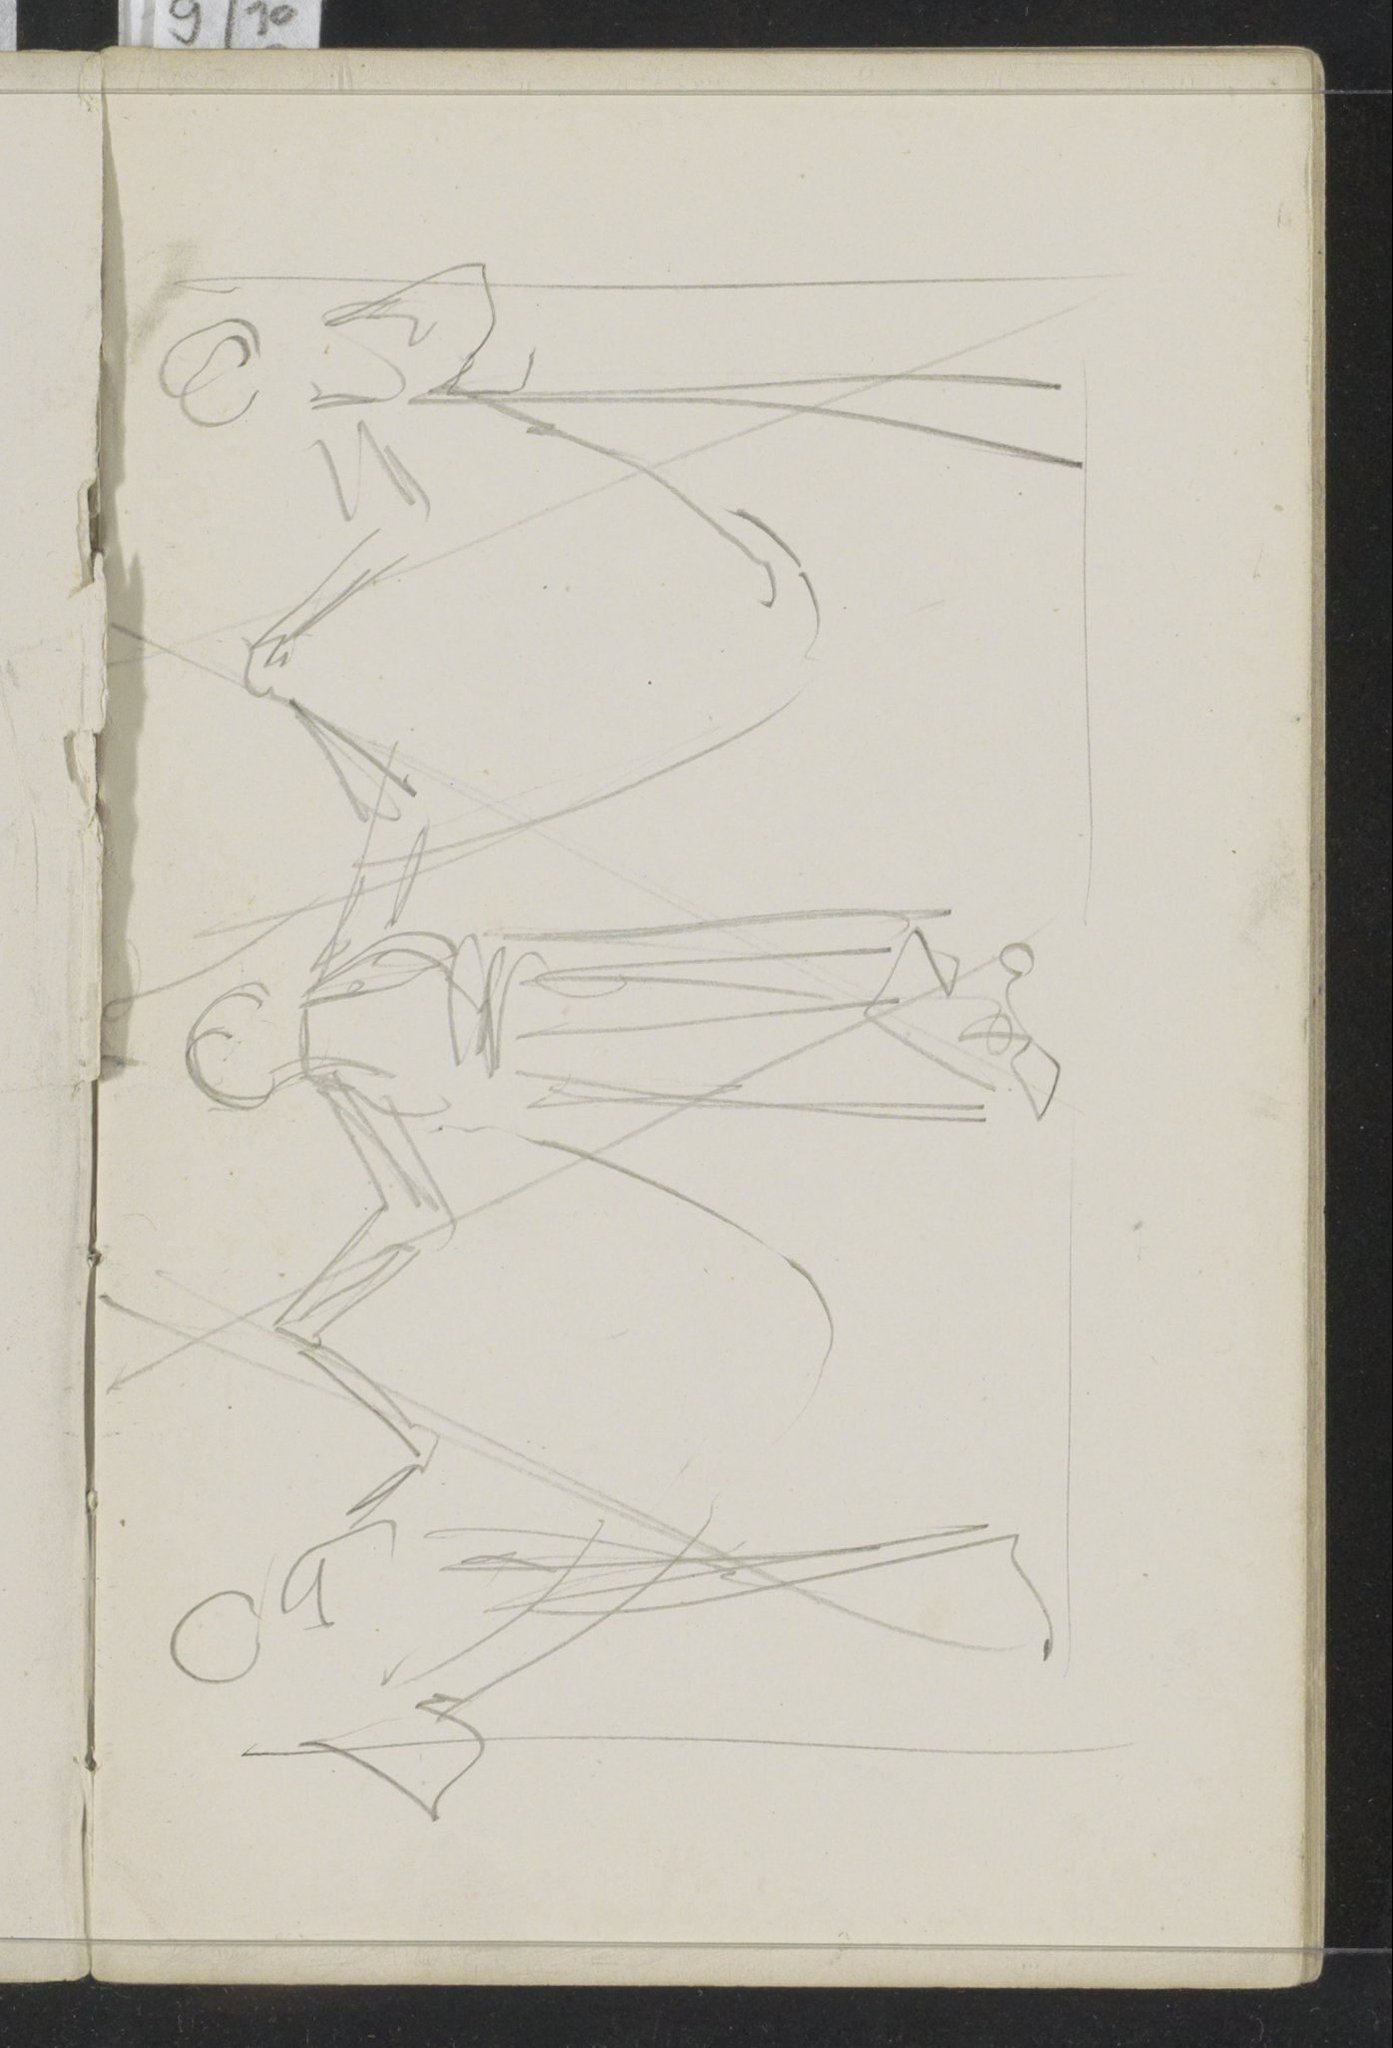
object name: sketchbook leaf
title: Drie vrouwfiguren die elkaars hand vasthouden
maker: carel adolph lion cachet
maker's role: draughtsman, print maker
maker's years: 1864-1945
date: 1874-1945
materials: paper, pencil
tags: adult woman, gripping someone by the hand or the wrist; clasped hands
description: De vrouwen hebben de handen opgeheven tot schouderhoogte. Blad 7 recto uit een schetsboek met 41 bladen.